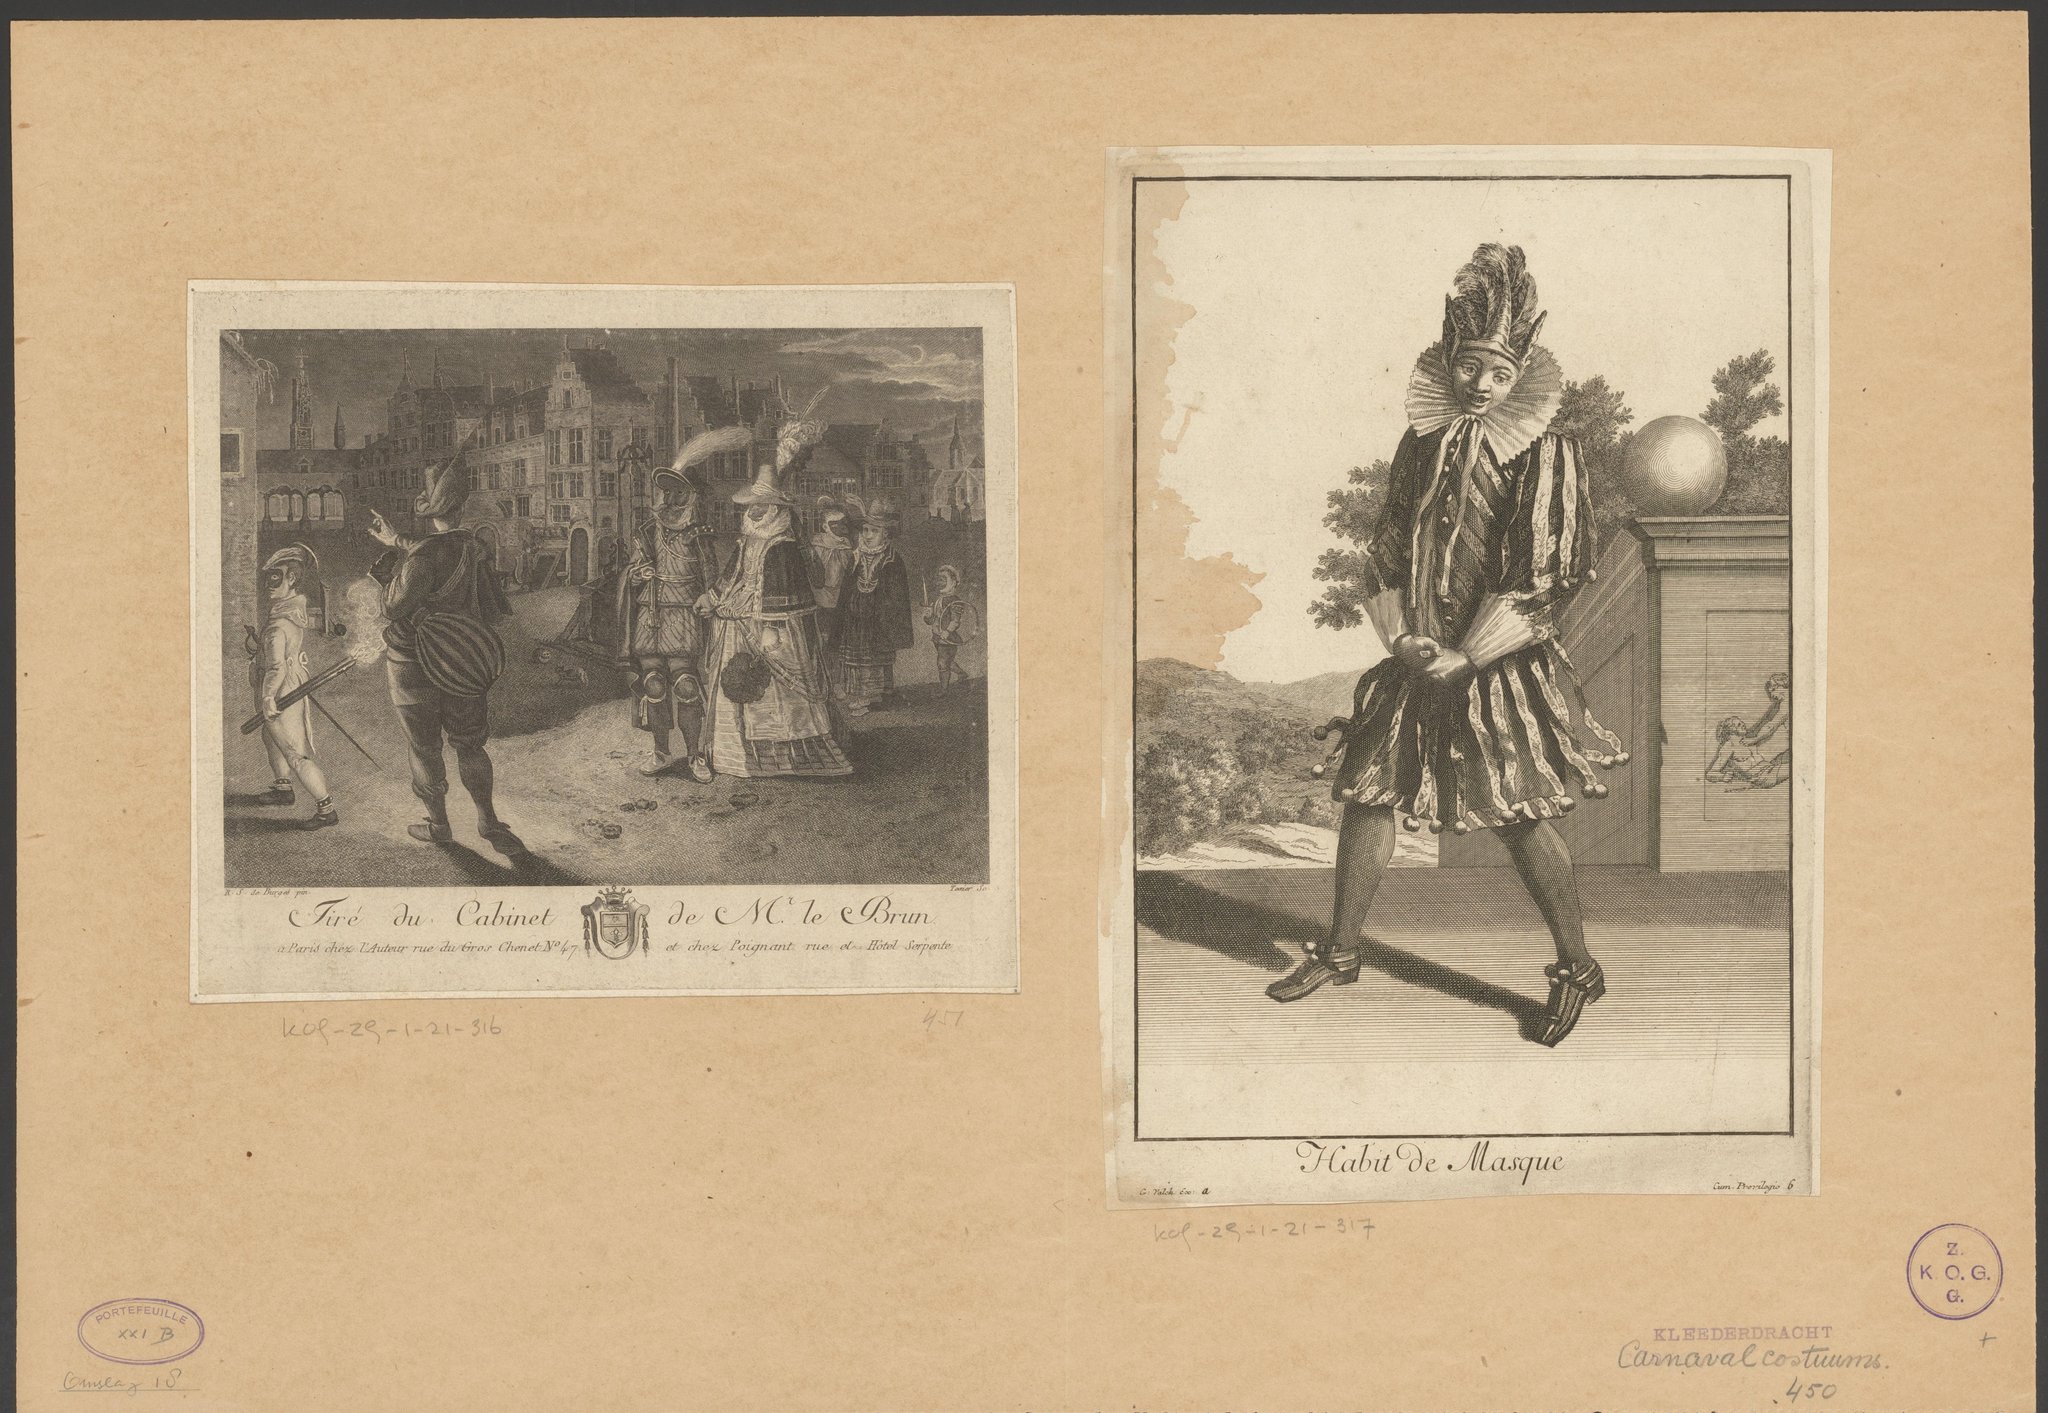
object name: print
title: Travestissements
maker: Anonymous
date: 1694-1715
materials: paper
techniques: engraving, etching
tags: mask, masquerade, masked ball, street, armorial bearing, heraldry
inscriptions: stamp: Lugt 1641, stamp, collector's mark: Lugt 1641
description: Linksonder genummerd: a en rechtsonder genummerd: 6. Onderwerpsrubrieken binnen de Atlas Zeden en Gewoonten: Zeden en Gewoonten in Engeren Zin, De Kleeding, Kleederdrachten (tijdvakken), Carnavalcostuums.